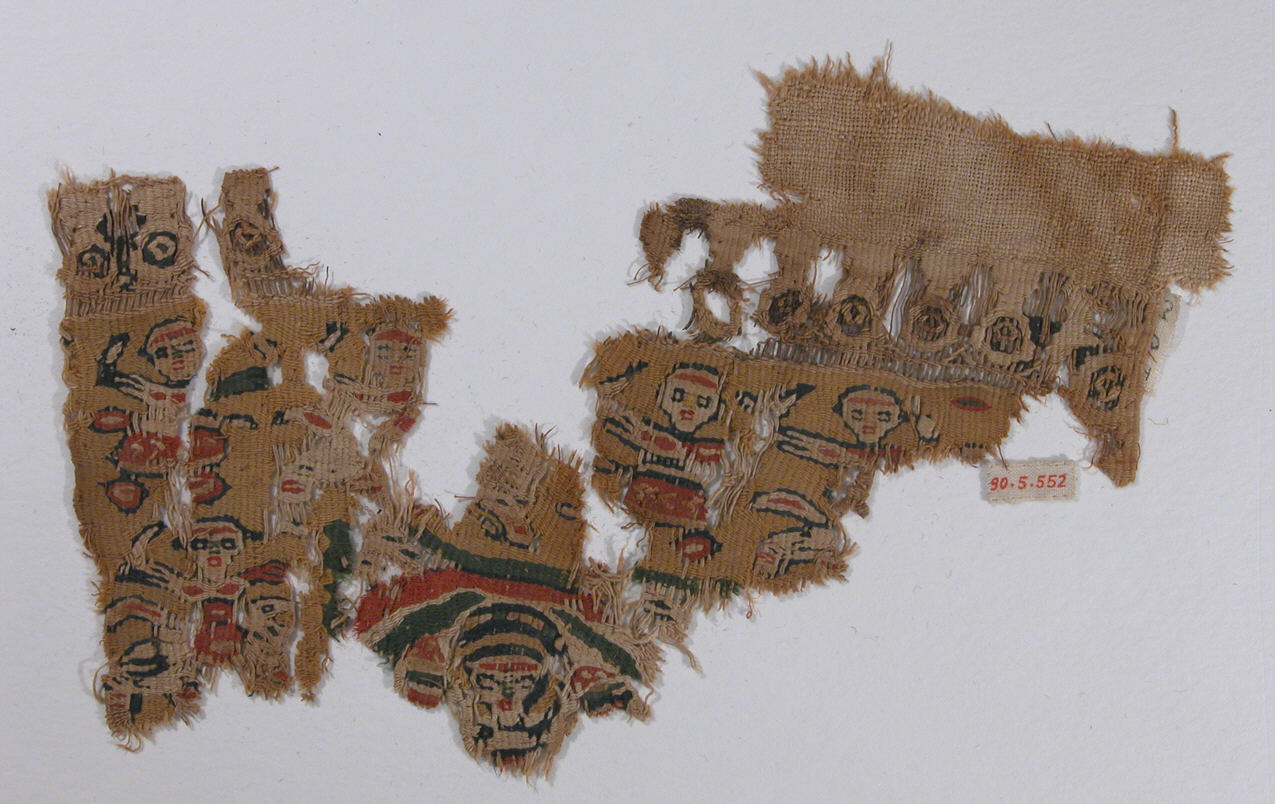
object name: textile fragment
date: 501-700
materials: linen, wool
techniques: weave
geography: egypt